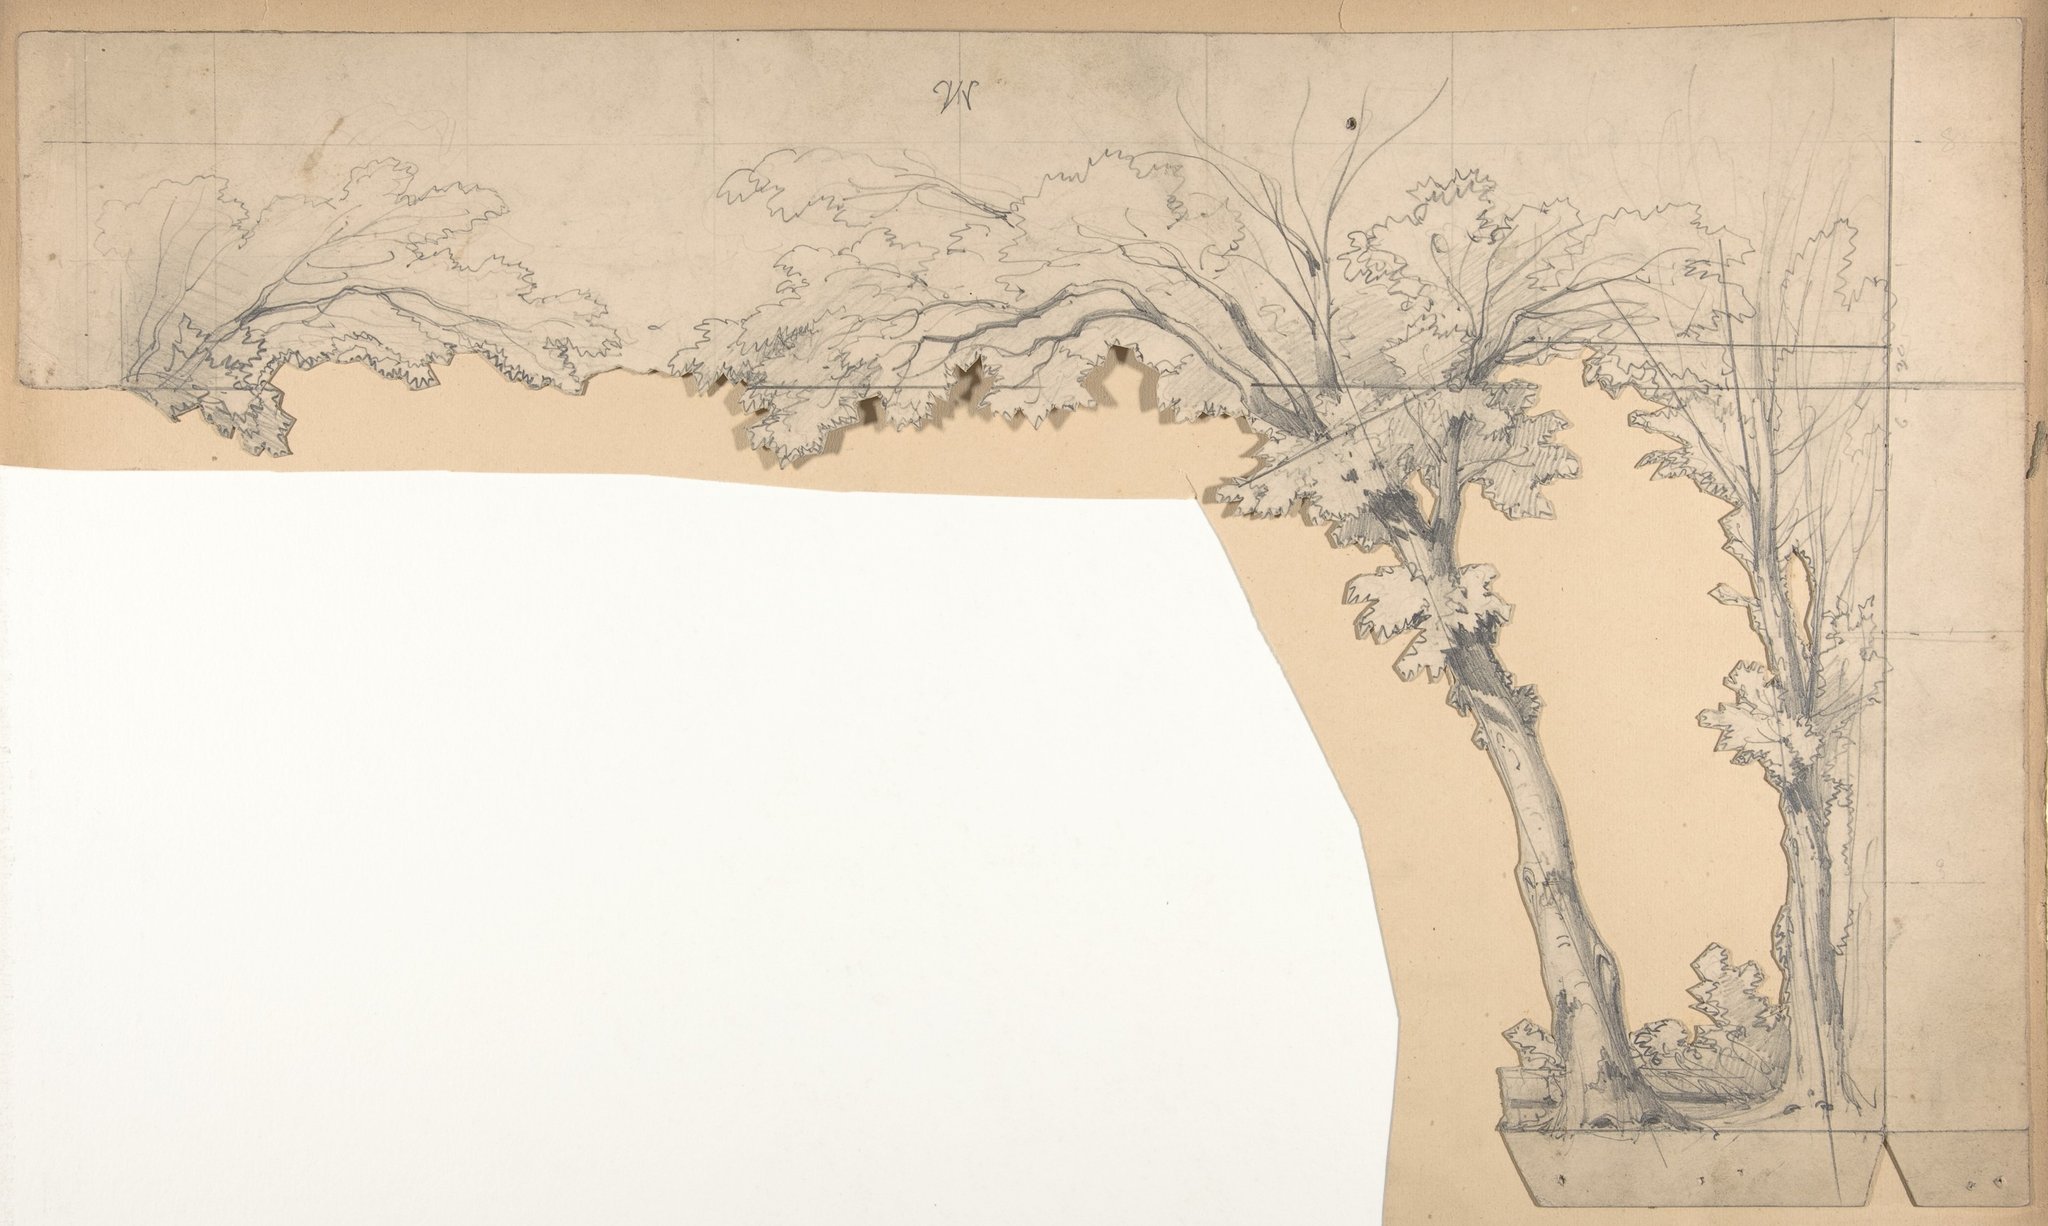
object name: drawing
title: Design for a Stage Set at the Opéra, Paris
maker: eugène cicéri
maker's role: artist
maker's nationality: french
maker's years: 1813-1890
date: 1801-1900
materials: graphite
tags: trees,stage design